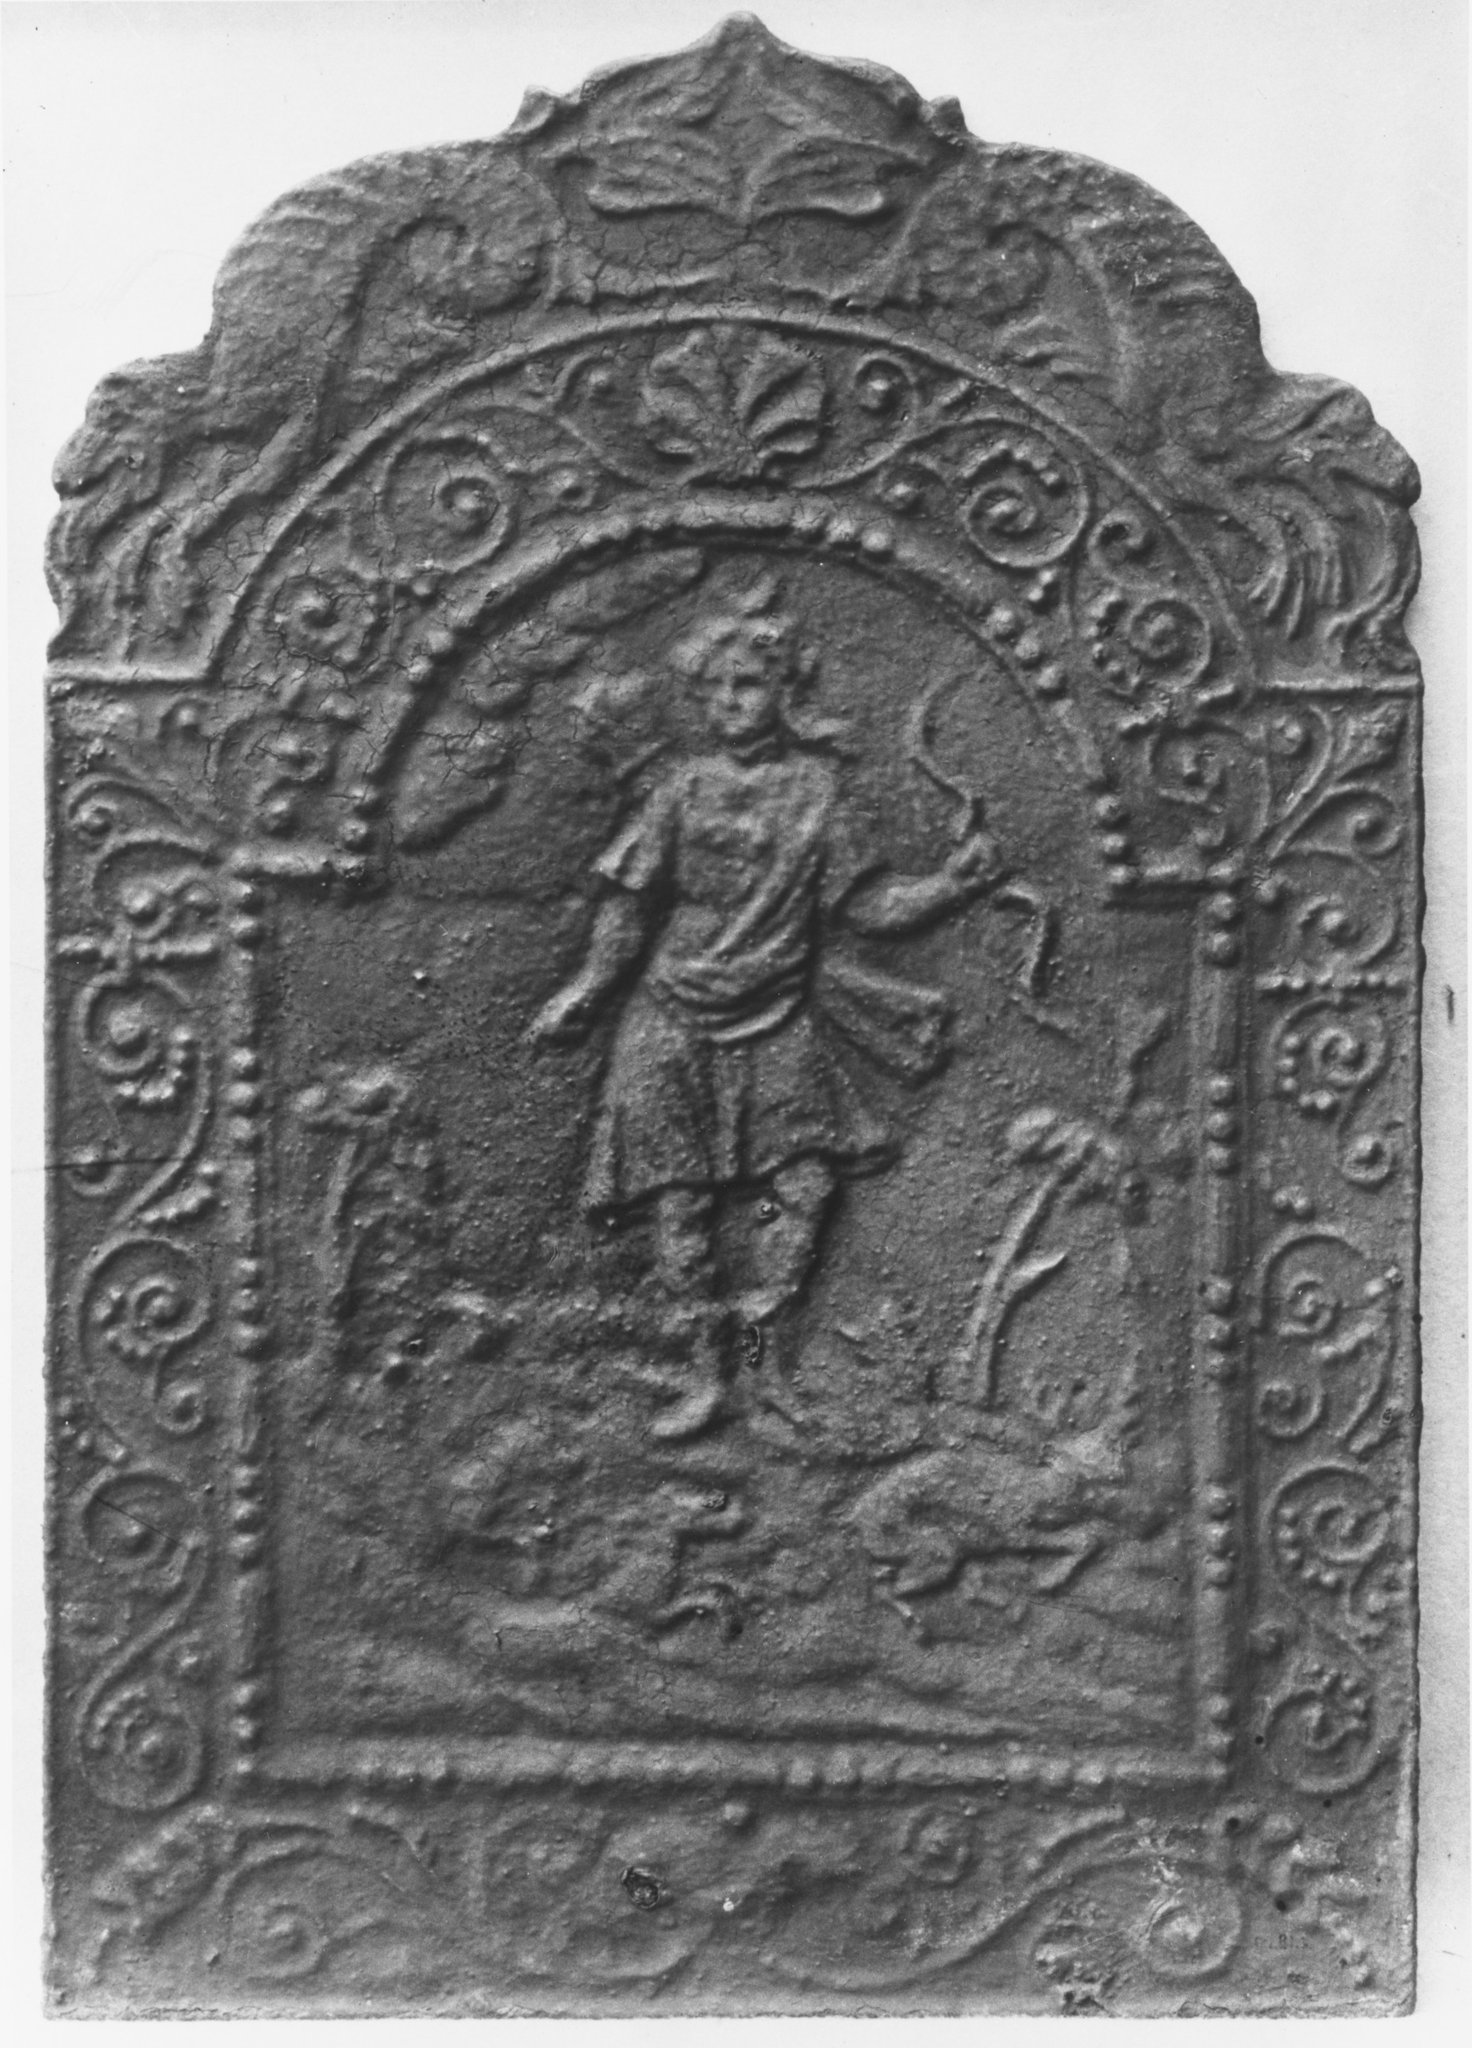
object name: fireback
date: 1701-1800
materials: iron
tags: bow and arrow,men